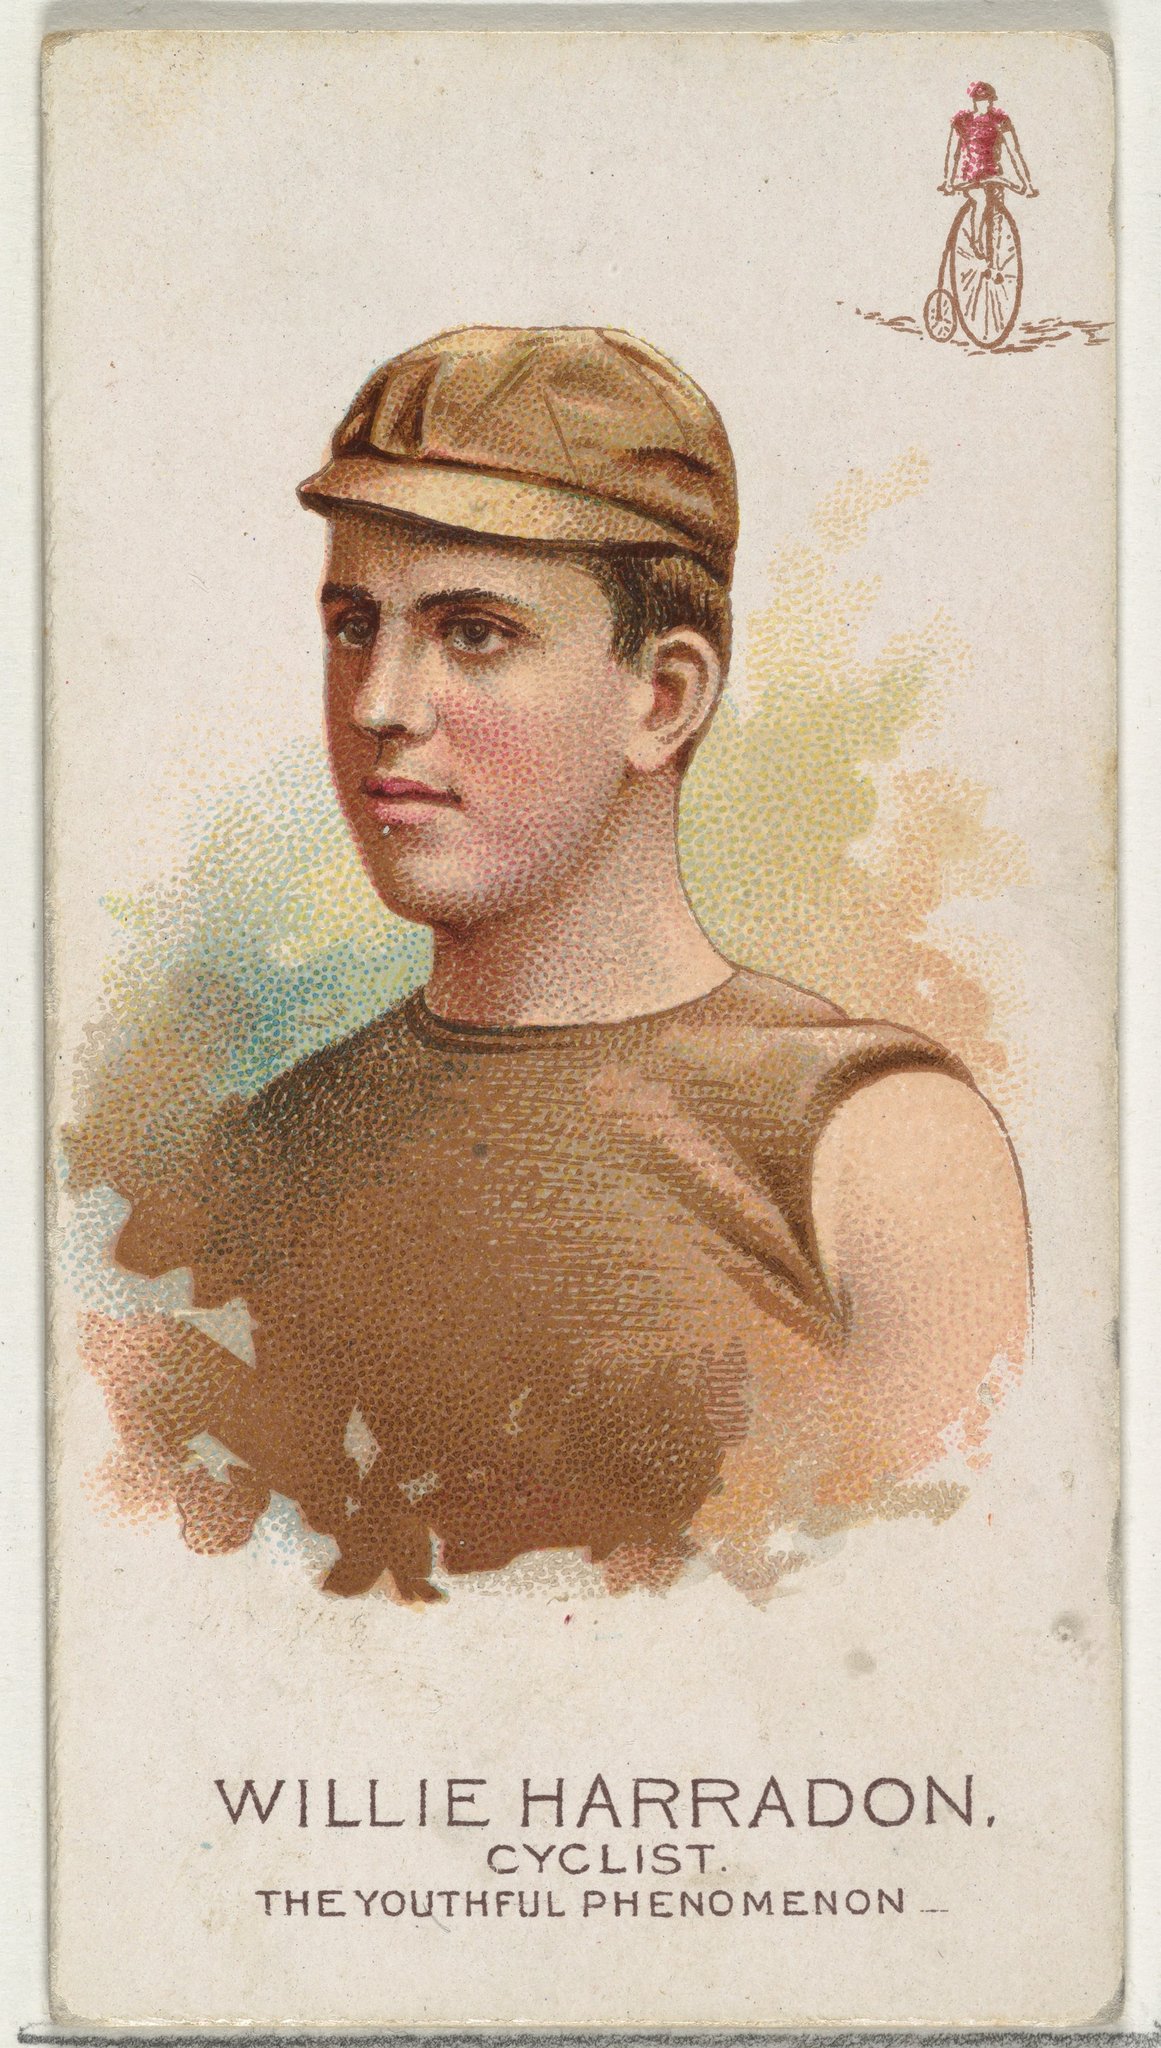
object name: print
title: Willie Harradon, Cyclist, The Youthful Phenomenon, from World's Champions, Series 2 (N29) for Allen & Ginter Cigarettes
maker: allen & ginter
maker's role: publisher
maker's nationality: american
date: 1888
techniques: color lithograph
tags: men,portraits,athletes